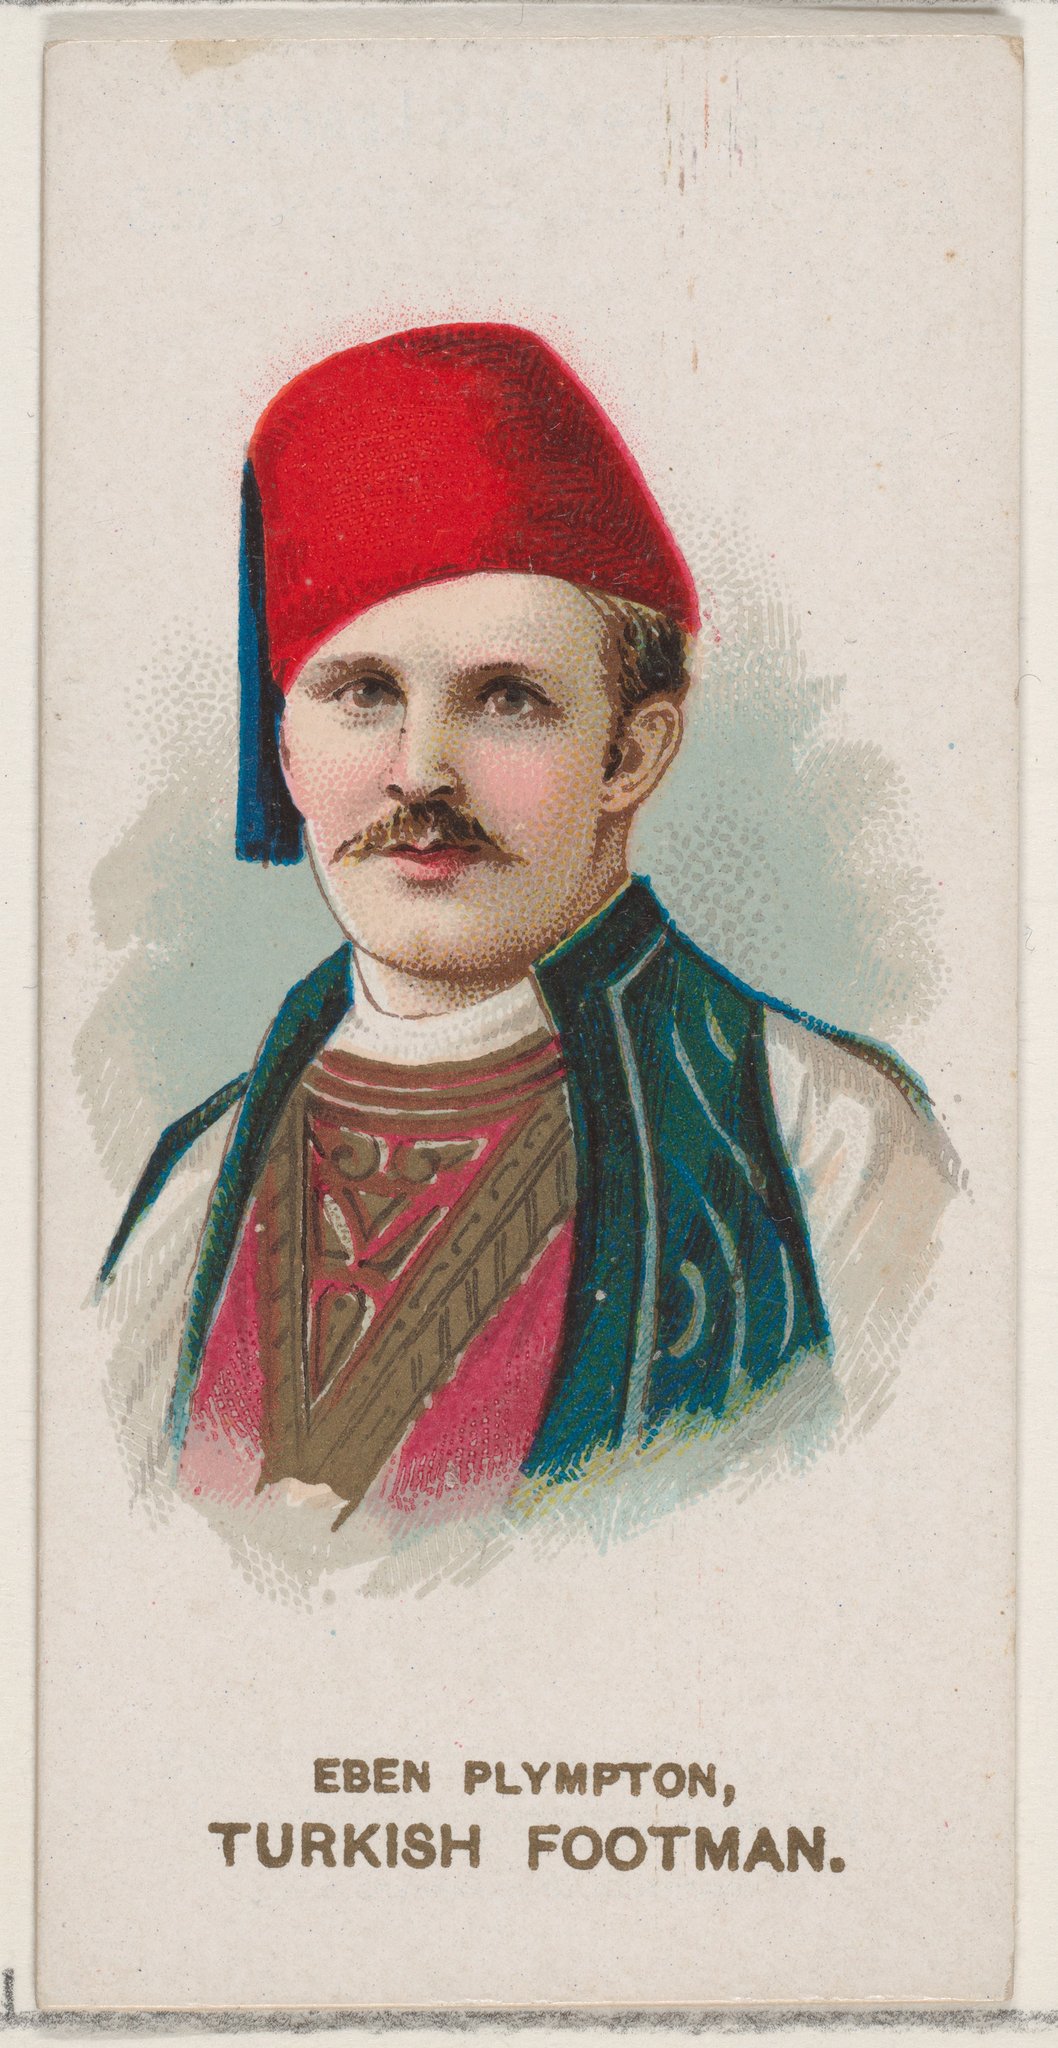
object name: print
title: Eben Plympton Dressed as Turkish Footman, from the set Actors and Actresses, Second Series (N71) for Duke brand cigarettes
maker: w. duke, sons & co.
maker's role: publisher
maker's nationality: american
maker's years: 1870-1920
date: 1888-1890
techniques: color lithograph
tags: men,actors